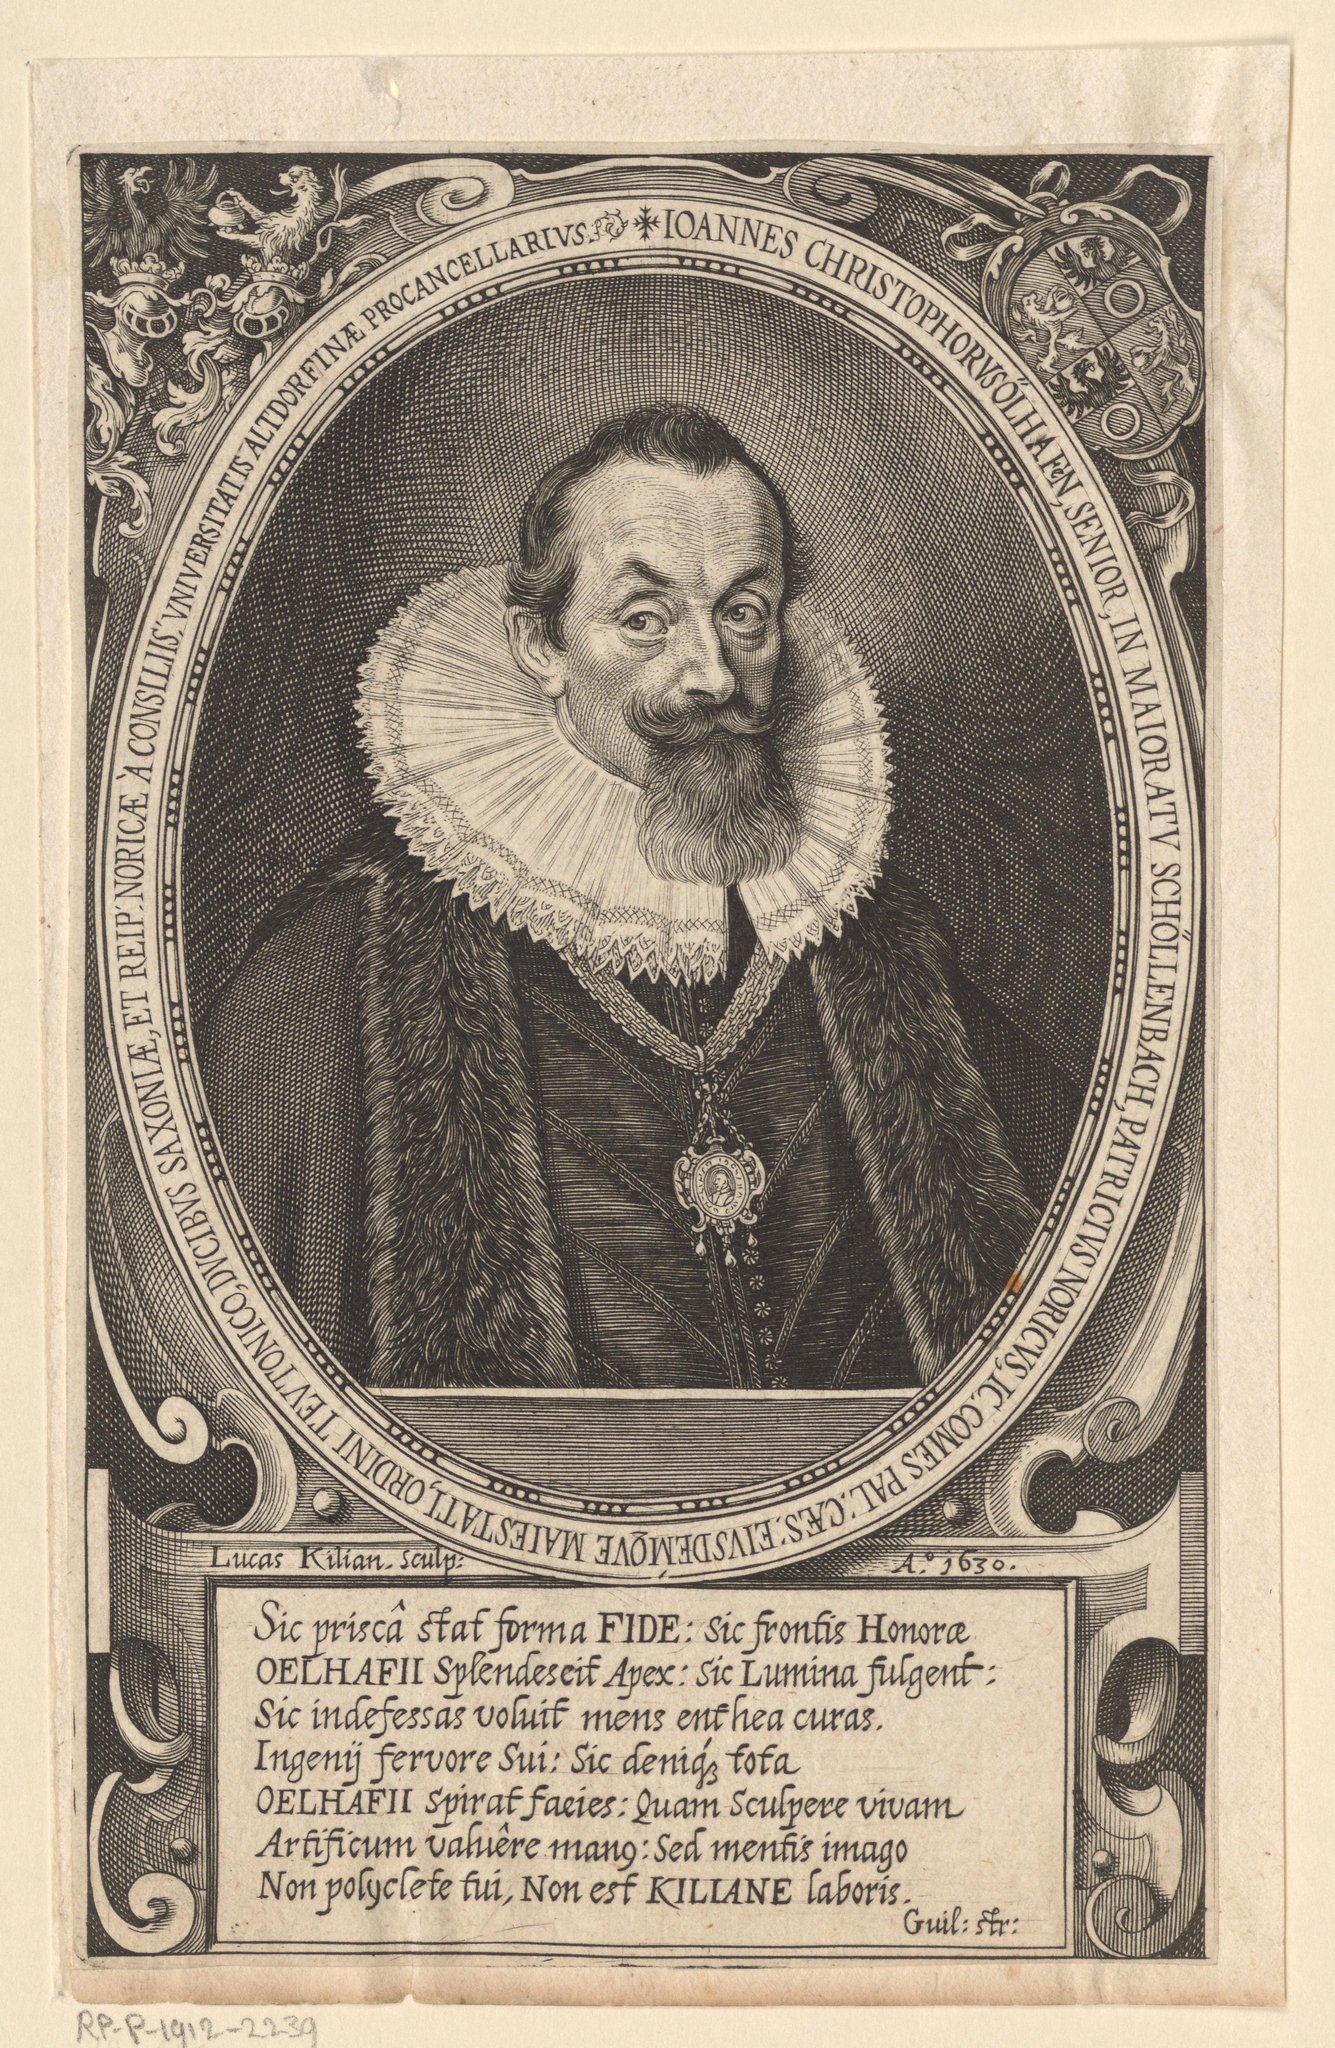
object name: print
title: Portret van Johann Christoph Oelhafen von Schöllenbach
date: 1630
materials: paper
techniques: engraving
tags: historical persons, lawyer, attorney at law, armorial bearing, heraldry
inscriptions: signature: ‘Guil: str:’, collector's mark: Lugt 2228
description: Onder het portret een zevenregelig vers.